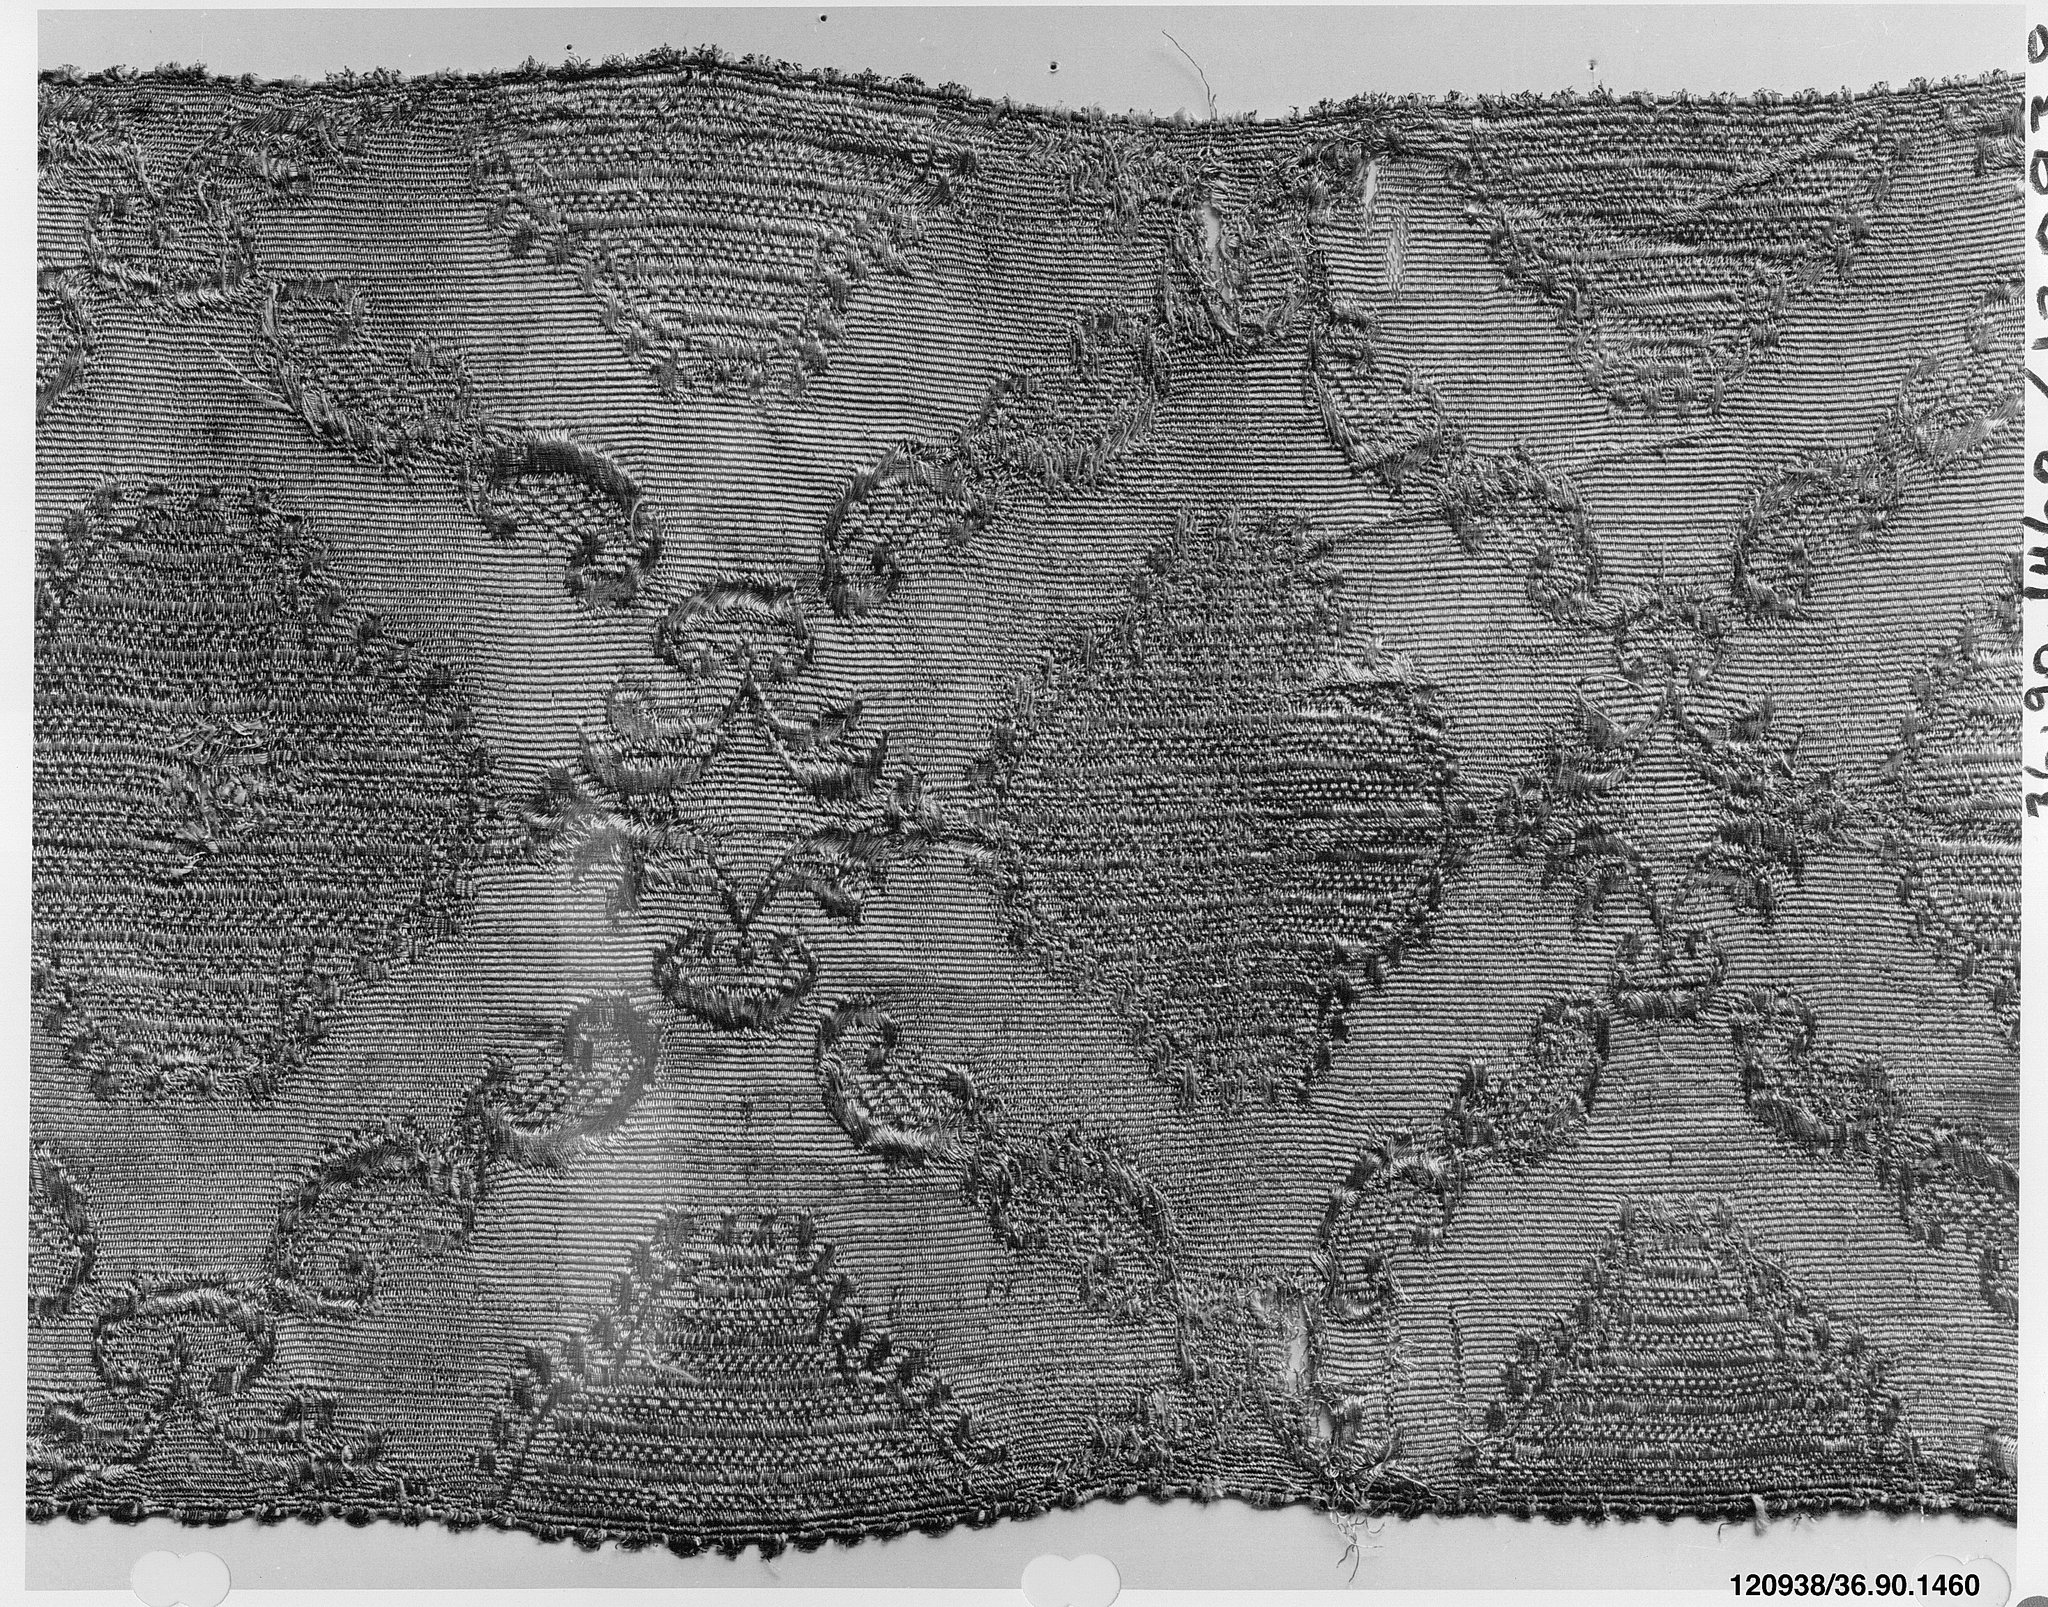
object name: piece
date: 1701-1800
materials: silk